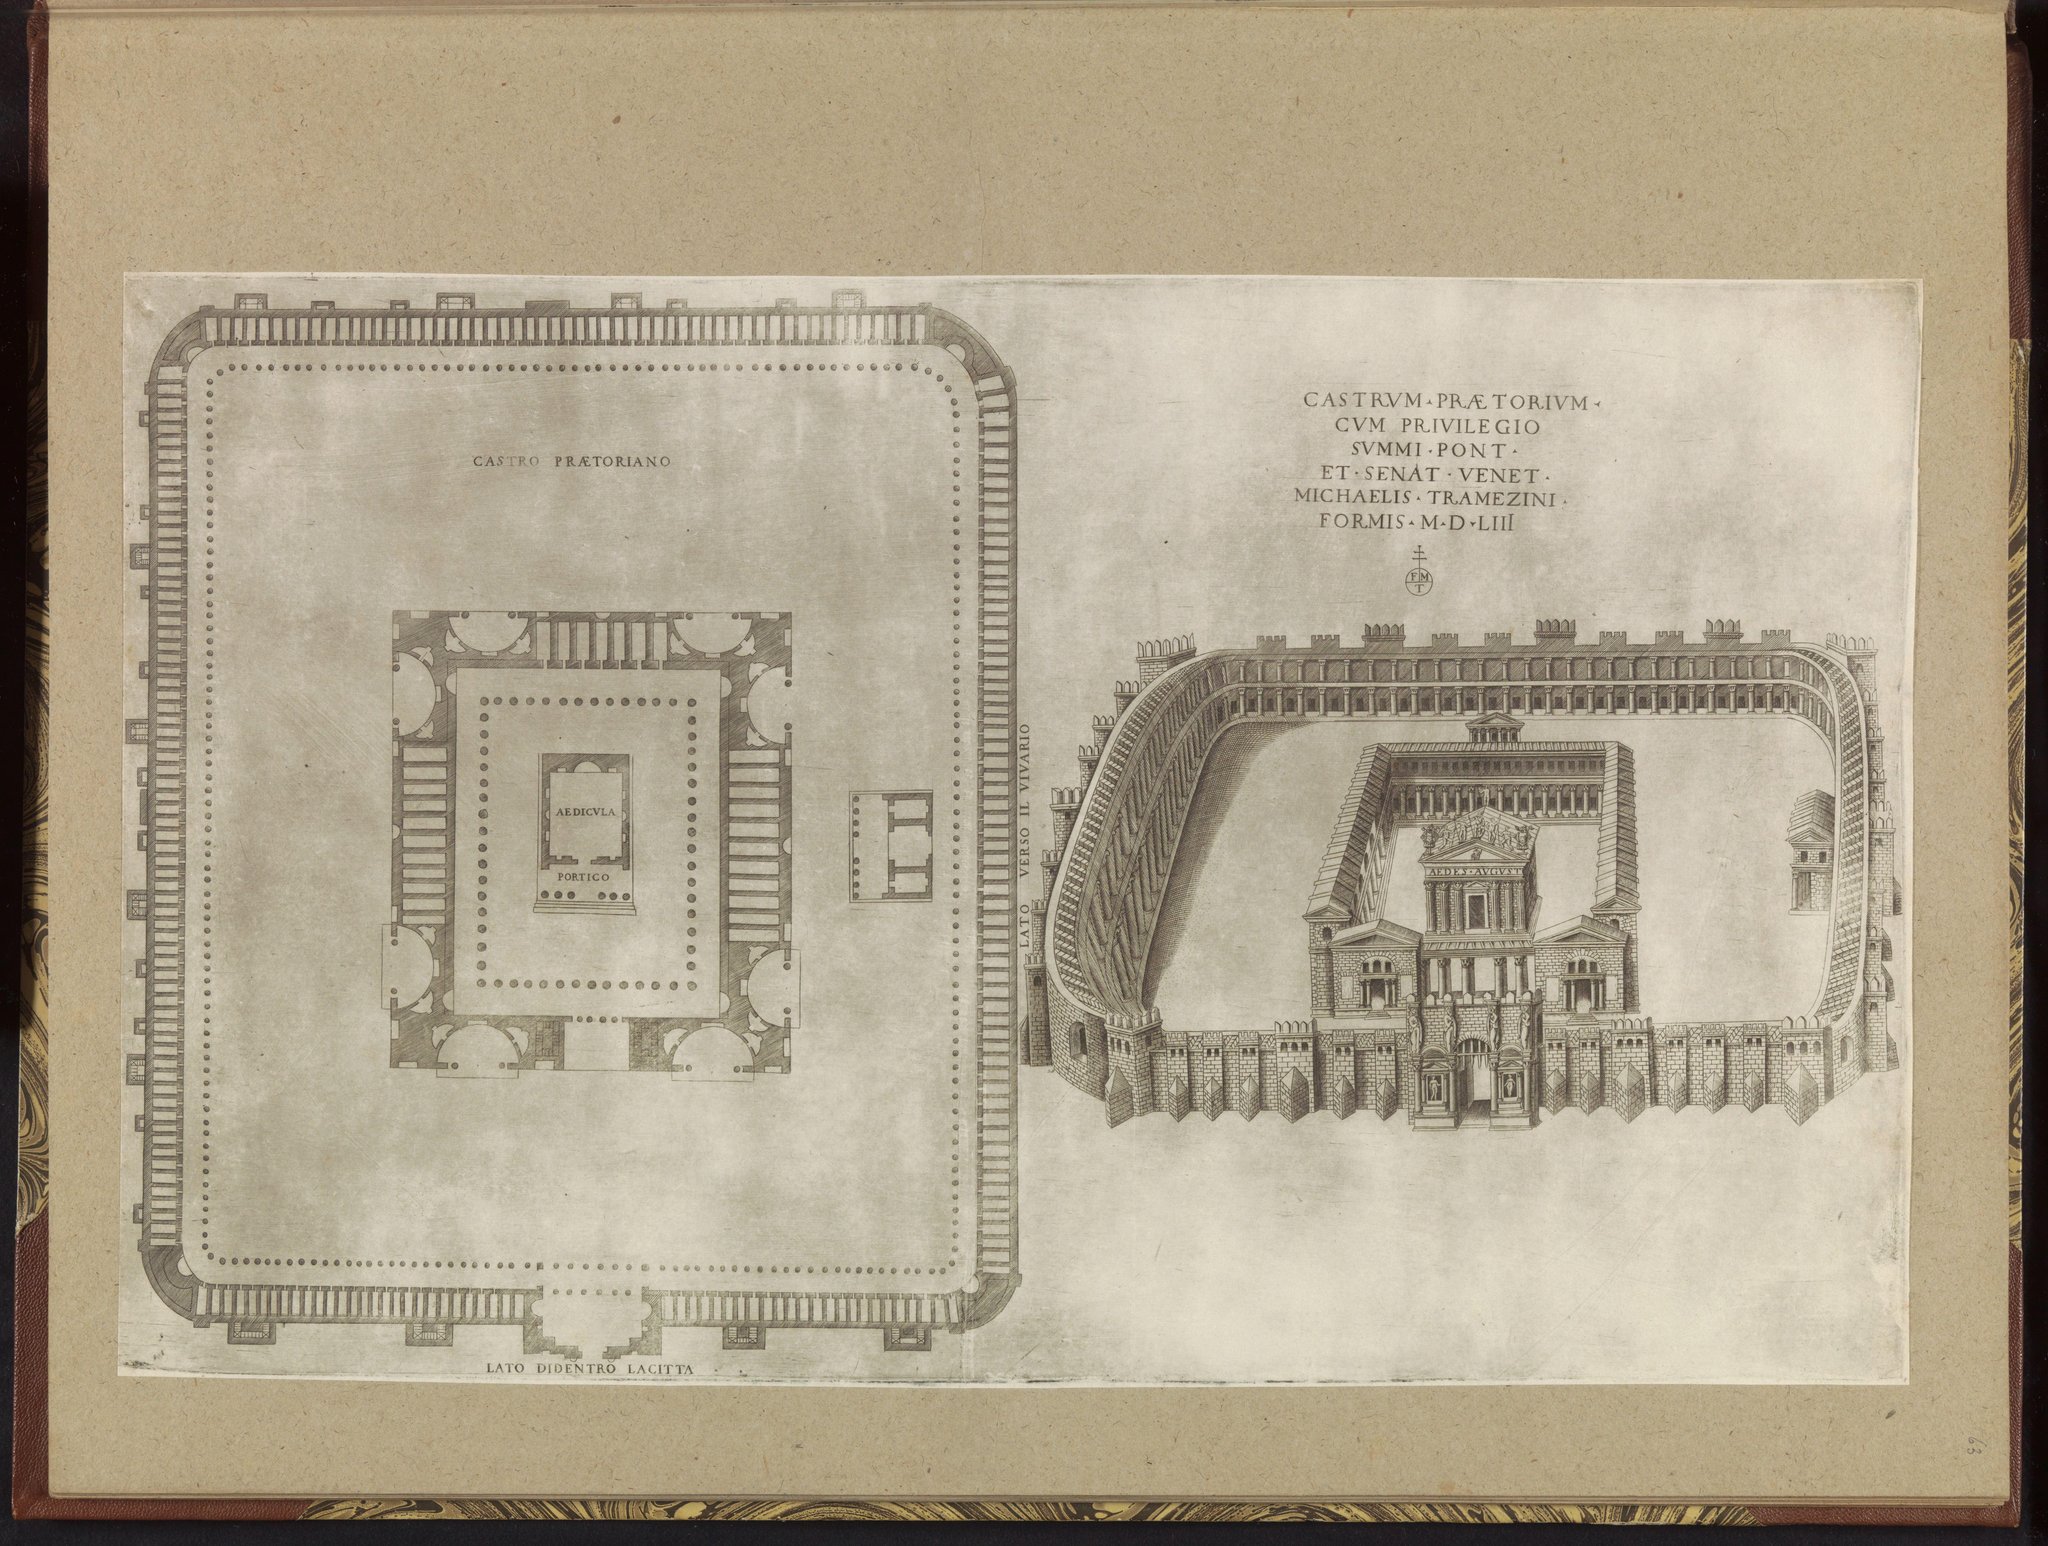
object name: album leaf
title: Speculum Romanae Magnificentiae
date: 1553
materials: paper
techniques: engraving, intaglio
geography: venice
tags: fortress, representation of real building (either existing or having existed), rome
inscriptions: date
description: Deze prent behoort tot het prentcorpus dat bekend staat als de ‘Speculum Romanae Magnificentiae’ (‘Spiegel van Romeinse pracht’). Dit corpus, bestaande uit prenten met voorstellingen van kunstwerken en gebouwen uit het antieke en het moderne Rome, vond zijn oorsprong bij uitgevers Antonio Salamanca en Antonio Lafreri. Deze twee buitenlandse uitgevers bundelden hun krachten te Rome in de periode 1553-1563. Hun prenten werden al snel razend populair bij toeristen en verzamelaars, die de prenten individueel of in grote groepen aanschaften. Grote groepen Speculum-prenten werden vaak op aanvraag samengebonden in albums. Er zijn verschillende Speculum-albums overgeleverd die allemaal verschillen van inhoud. Tussen 1573 en 1577 gaf Antonio Lafreri een speciale titelpagina uit (met de titel ‘Speculum Romanae Magnificentiae’) die mensen voor hun verzamelingen konden voegen. Het overlijden van Lafreri in 1577 betekende niet het einde van het corpus. Een groot deel van de koperplaten ging over op Claudio en Stefano Duchetti. De rest raakte verspreid over verschillende andere uitgevers. De populariteit van de Speculum-prenten wist nog geruime periode uitgevers te inspireren tot het laten maken van kopieën en het toevoegen van nieuwe prenten aan het corpus.